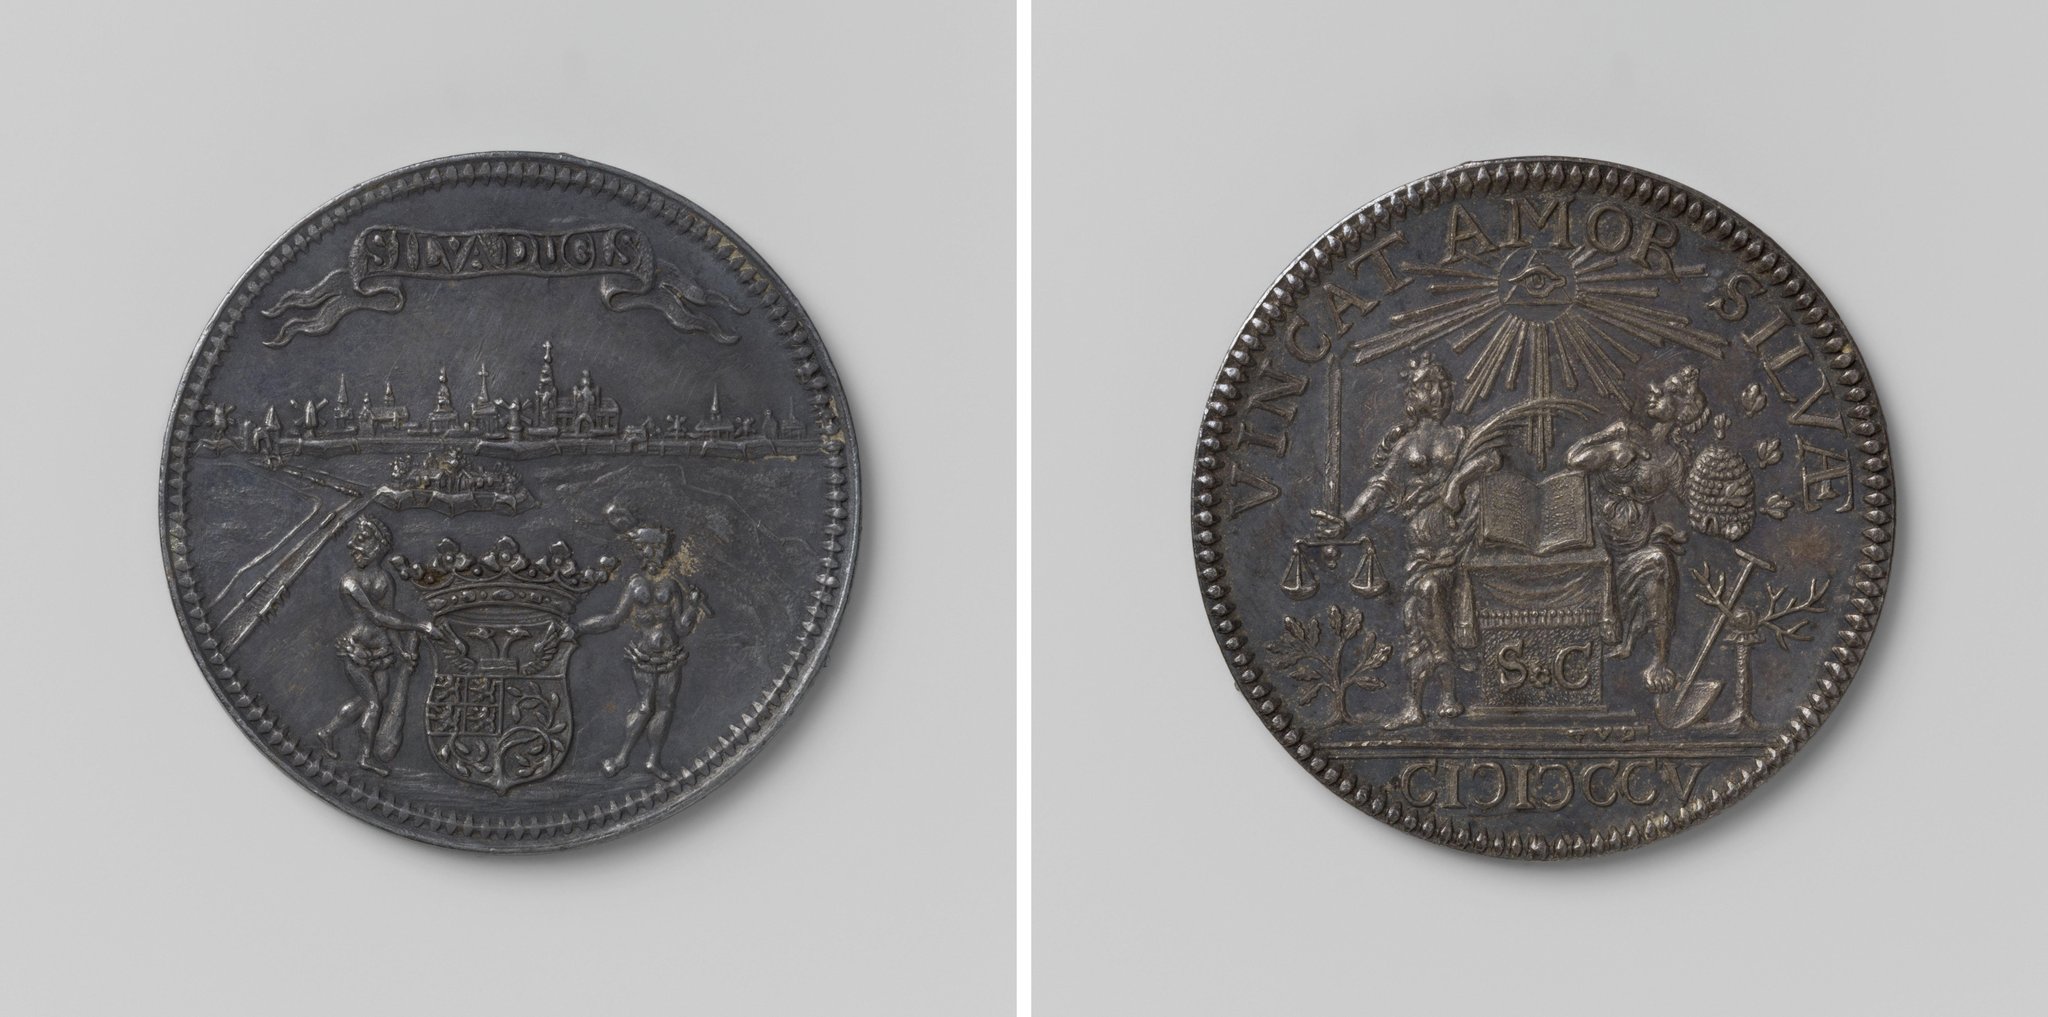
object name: council medal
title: Vroedschapspenning van de stad 's-Hertogenbosch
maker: theodorus casparus van berckel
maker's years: 1680-1734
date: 1705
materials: silver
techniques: striking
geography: den bosch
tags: den bosch